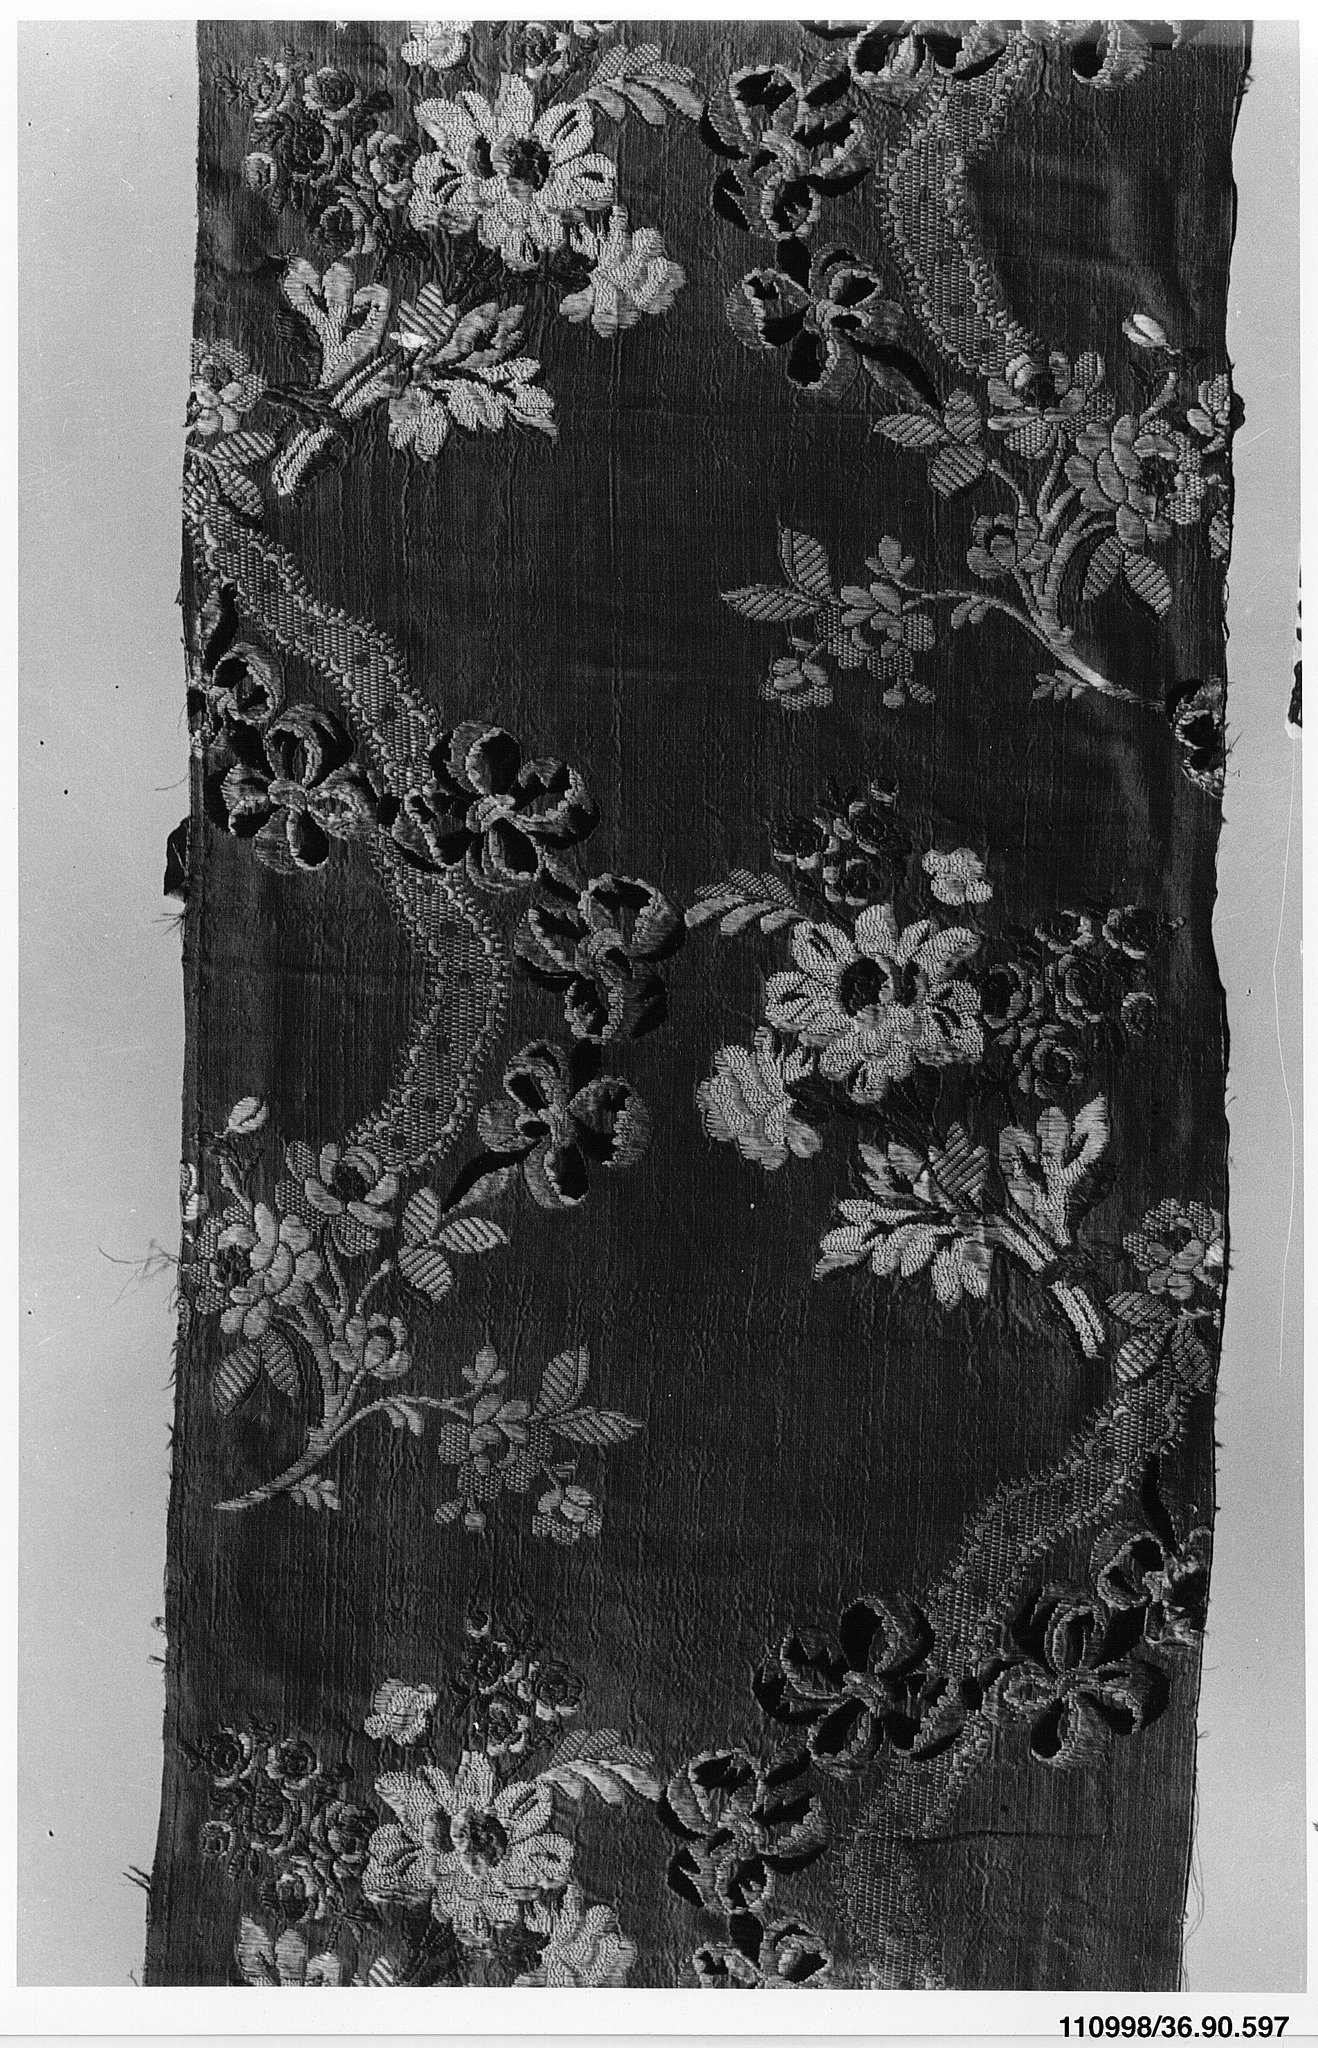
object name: piece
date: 1734-1766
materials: silk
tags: flowers